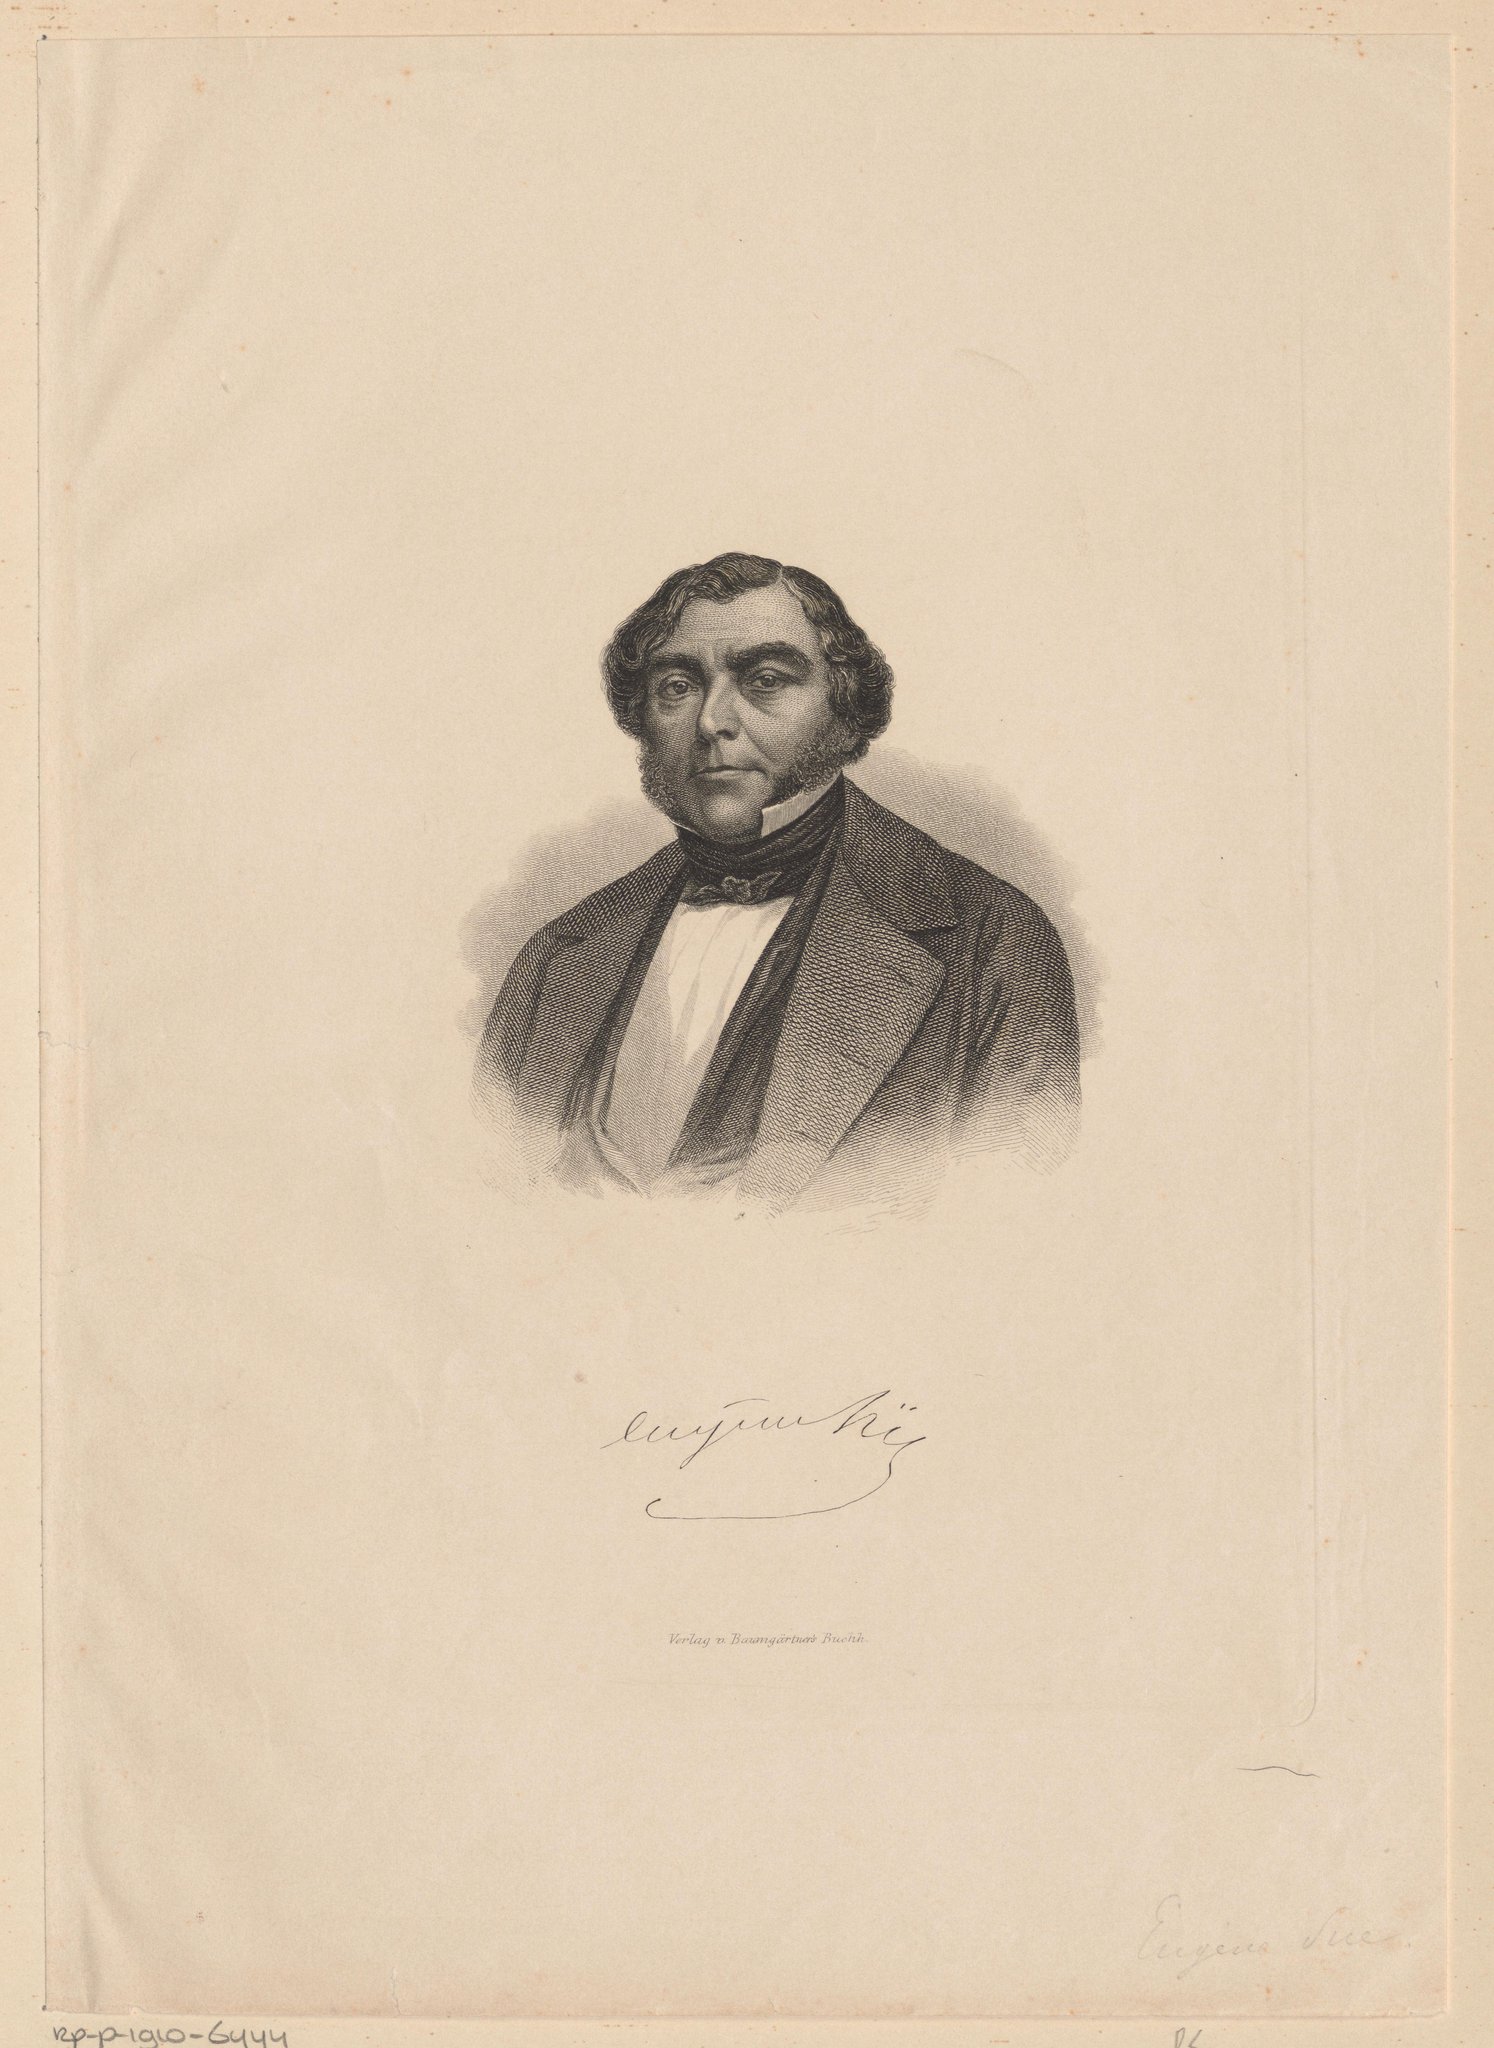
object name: print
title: Portret van Eugène Sue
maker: alexander alboth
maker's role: print maker, printer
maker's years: 1824-1888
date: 1834-1888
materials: paper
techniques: etching, engraving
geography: leipzig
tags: historical persons, portrait of a writer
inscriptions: collector's mark: Lugt 2228